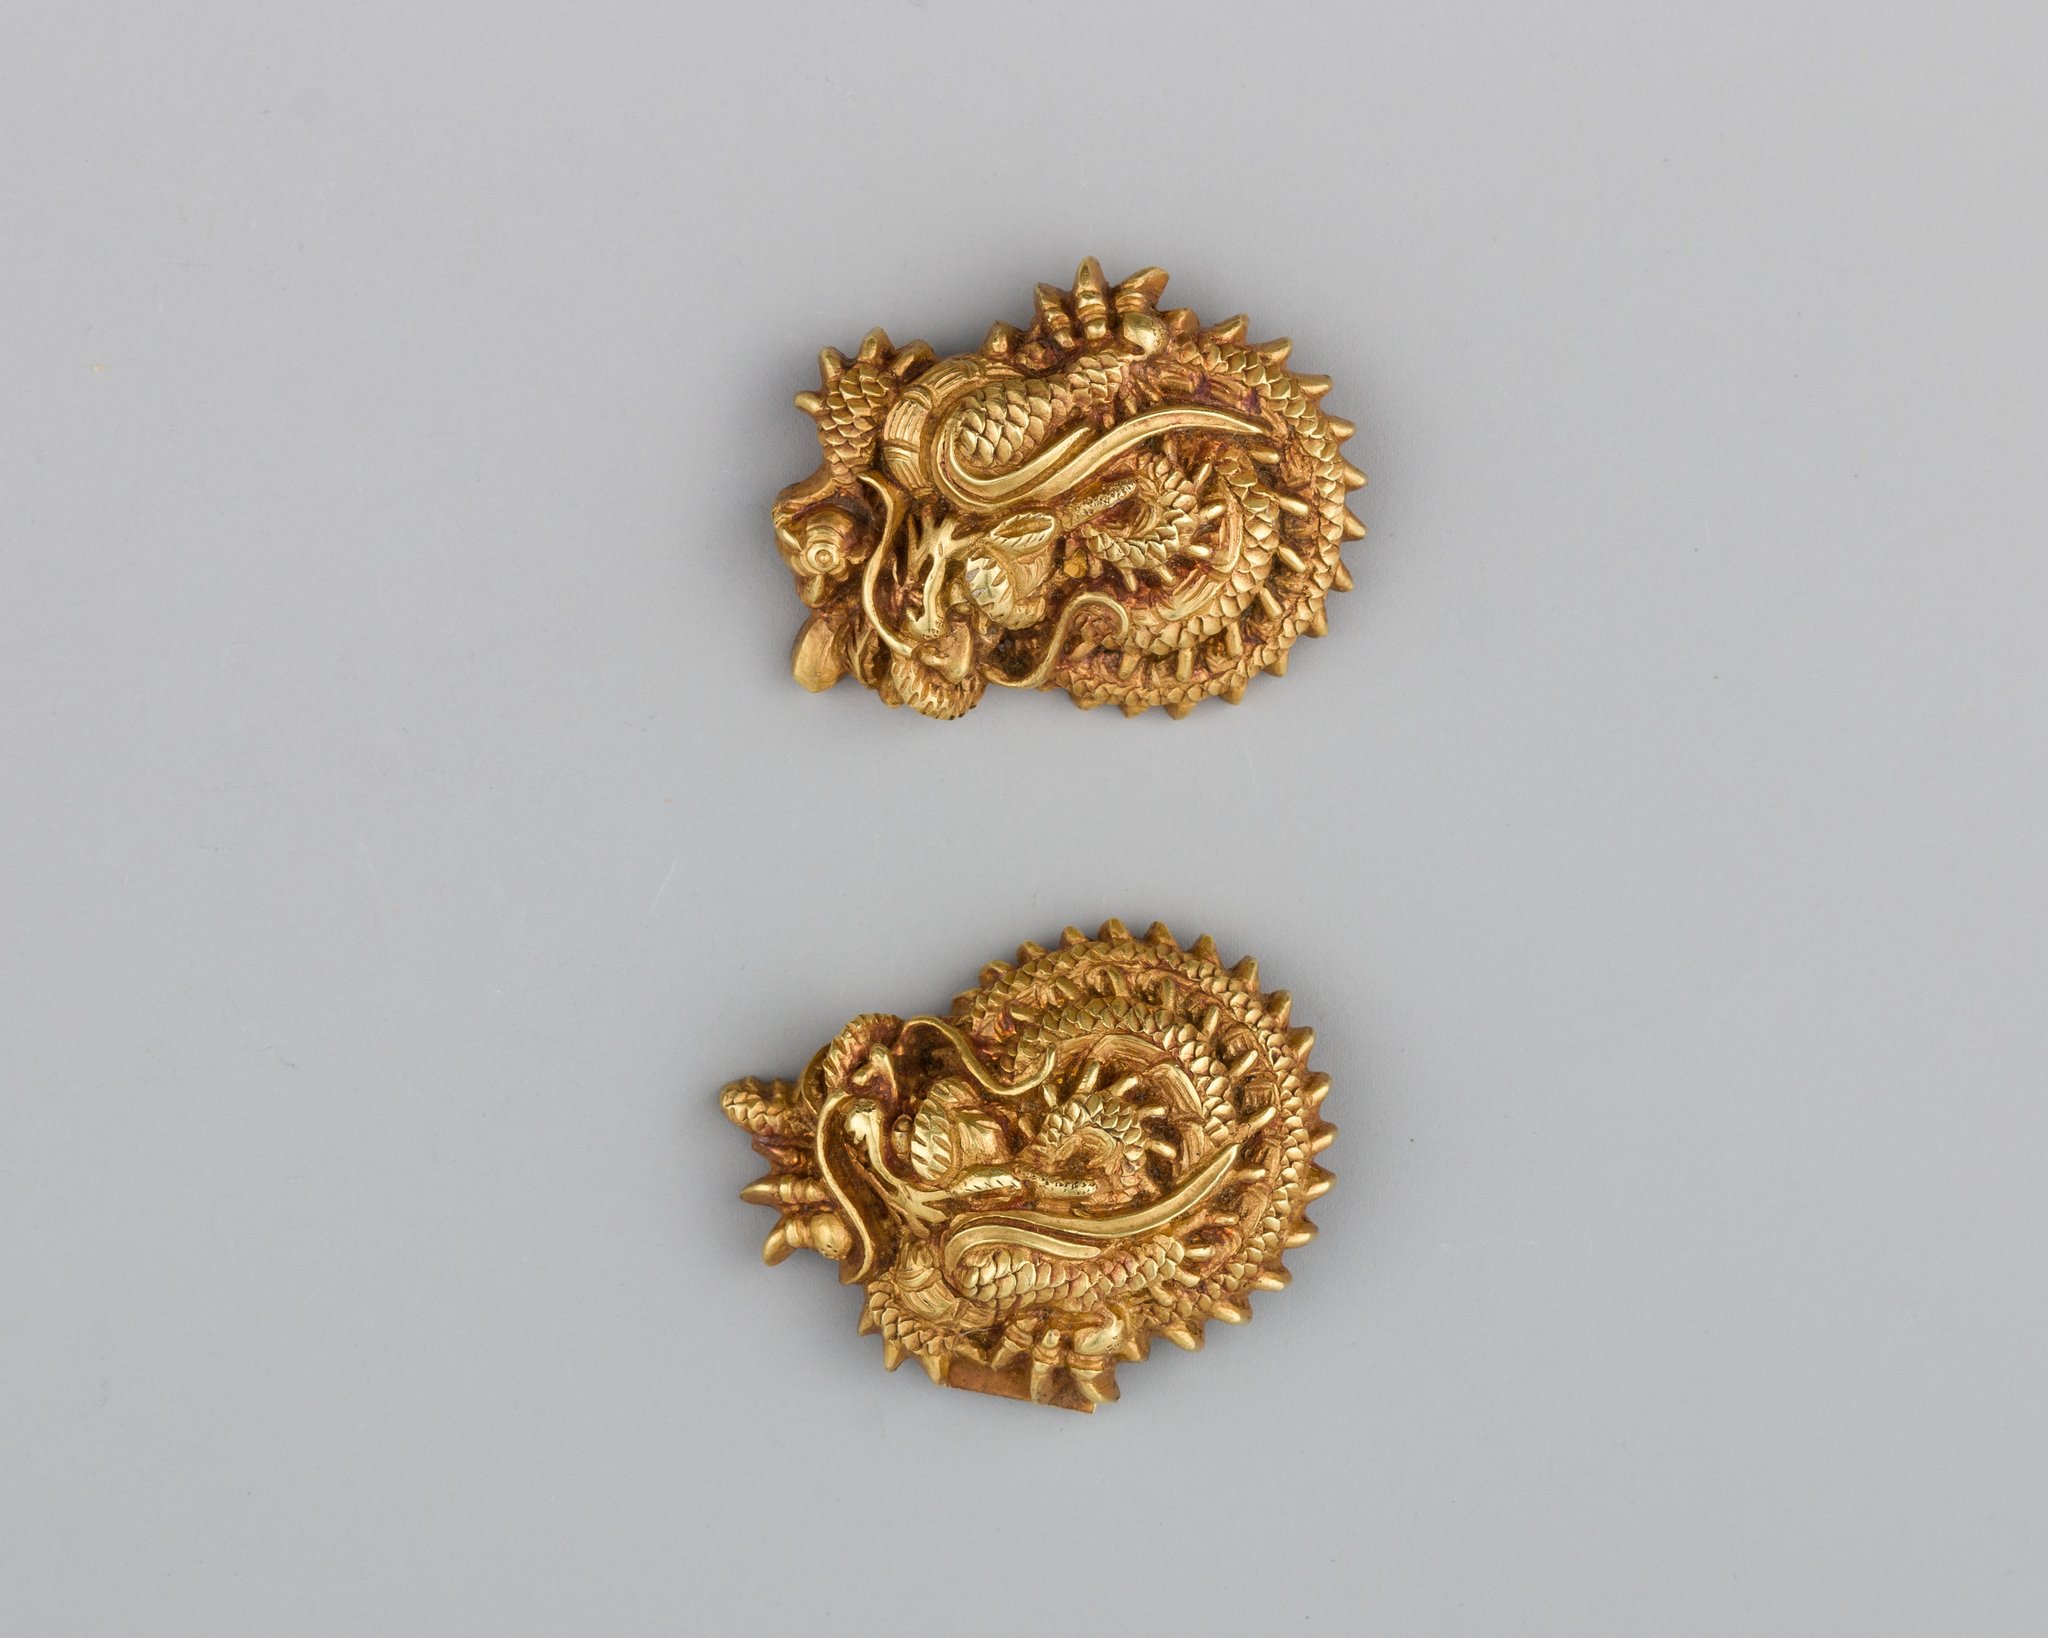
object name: pair of sword grip ornament menuki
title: Pair of Sword-Grip Ornaments (Menuki)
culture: japanese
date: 1701-1800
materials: gold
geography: japan